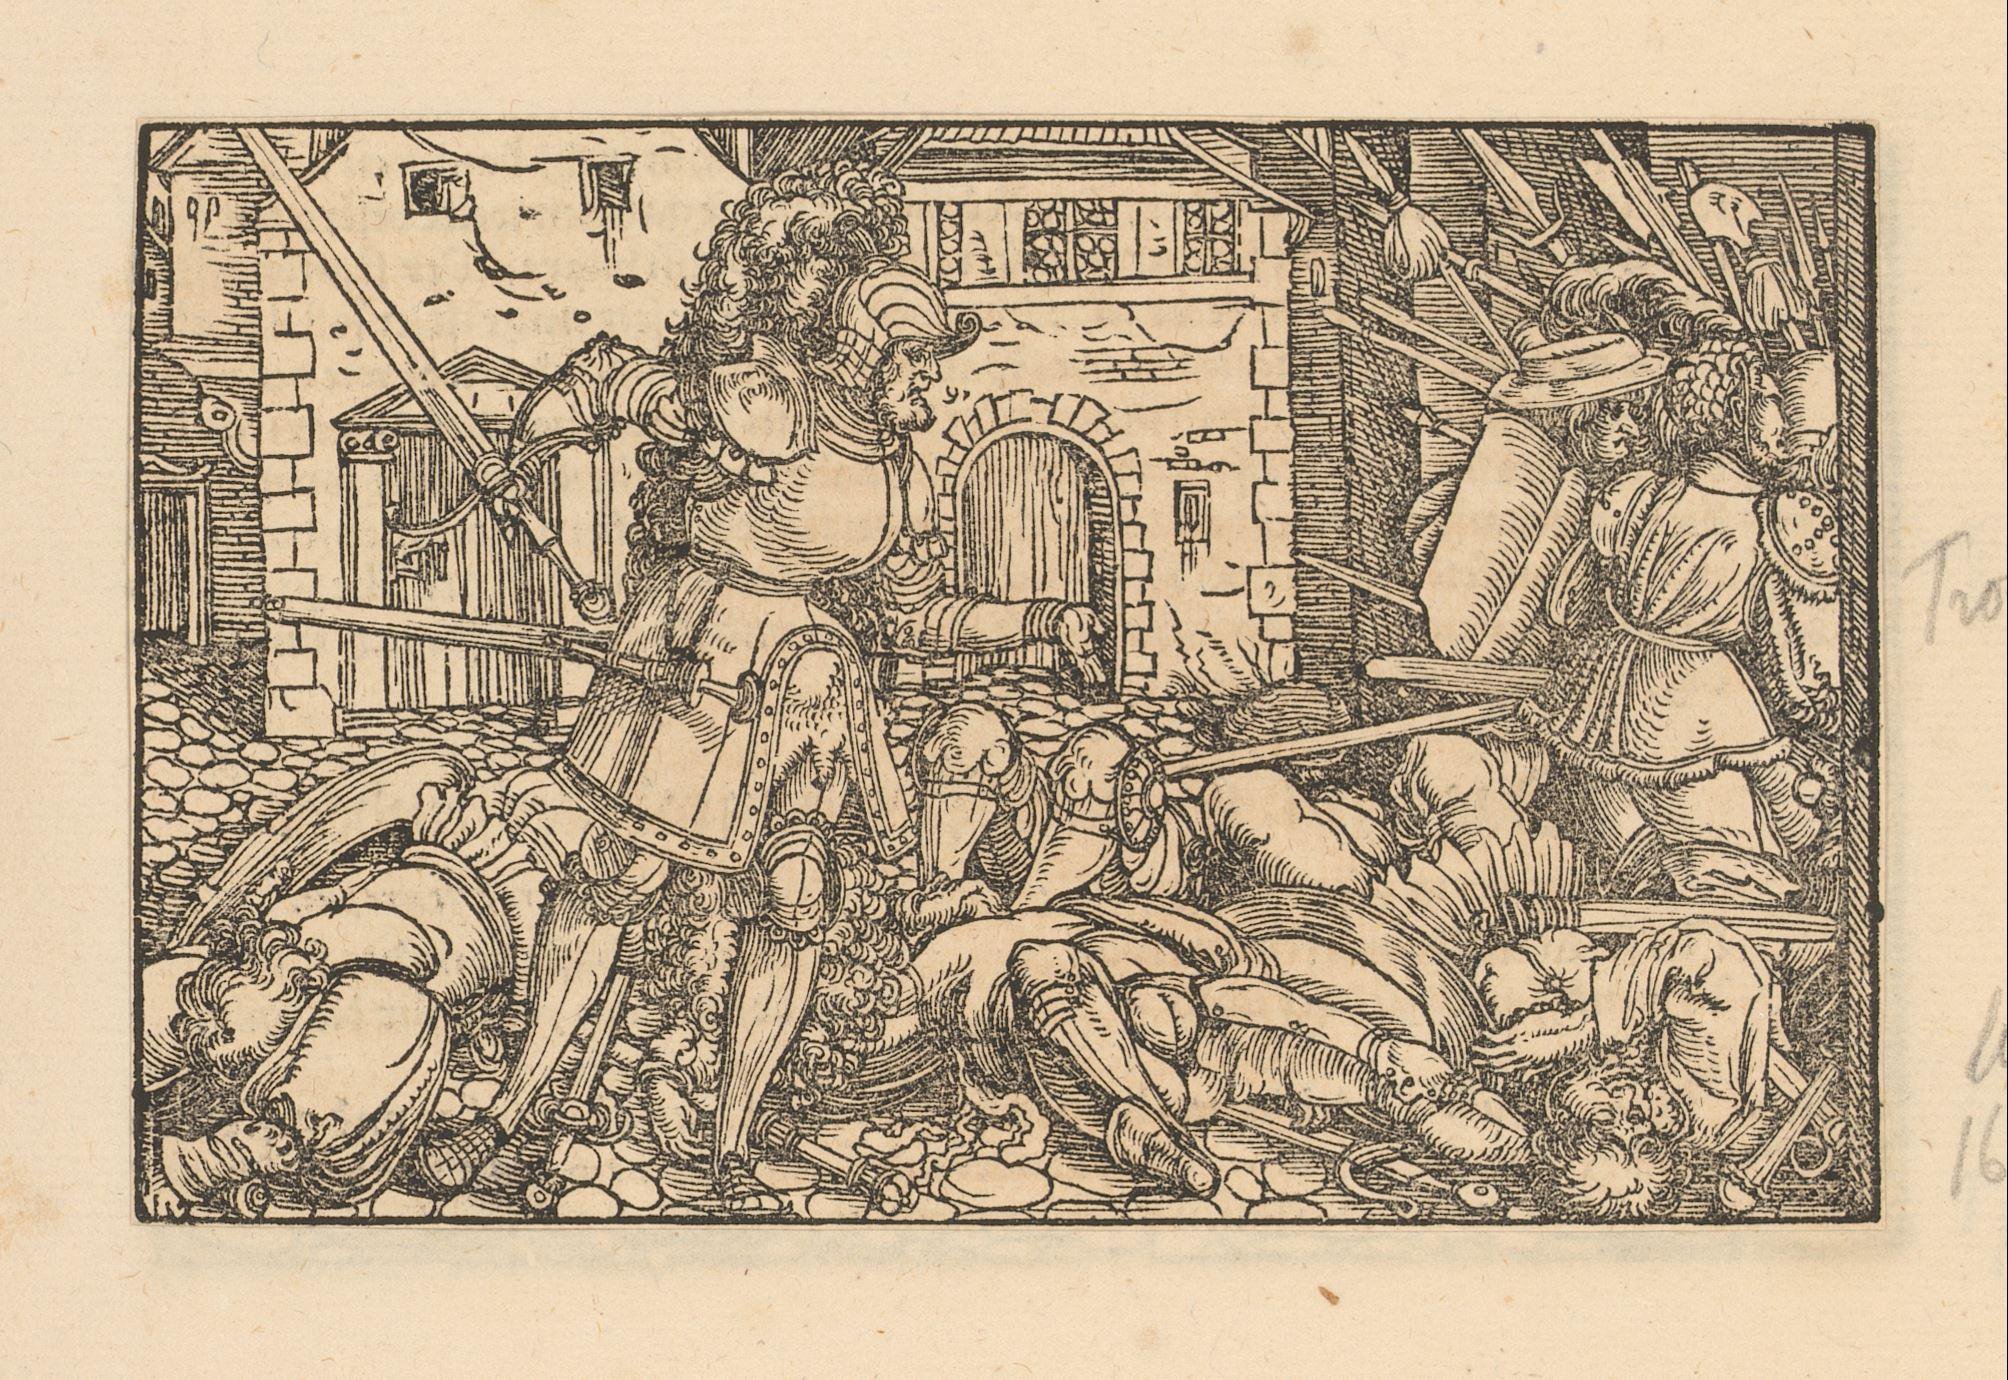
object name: print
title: Overwinnaars in een stad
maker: Anonymous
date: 1514-1532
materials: paper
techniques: letterpress printing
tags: siege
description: Deze prent is gebruikt in: Petrarca, Francesco. Von der Artzney bayder Glück, des guten und widerwertigen: unnd weß sich ain yeder inn Gelück und Unglück halten sol (...). Augsburg: Heinrich Steiner, 1532. Deze uitgave is ook bekend onder de titel 'Trostspiegel in Glück und Unglück'.